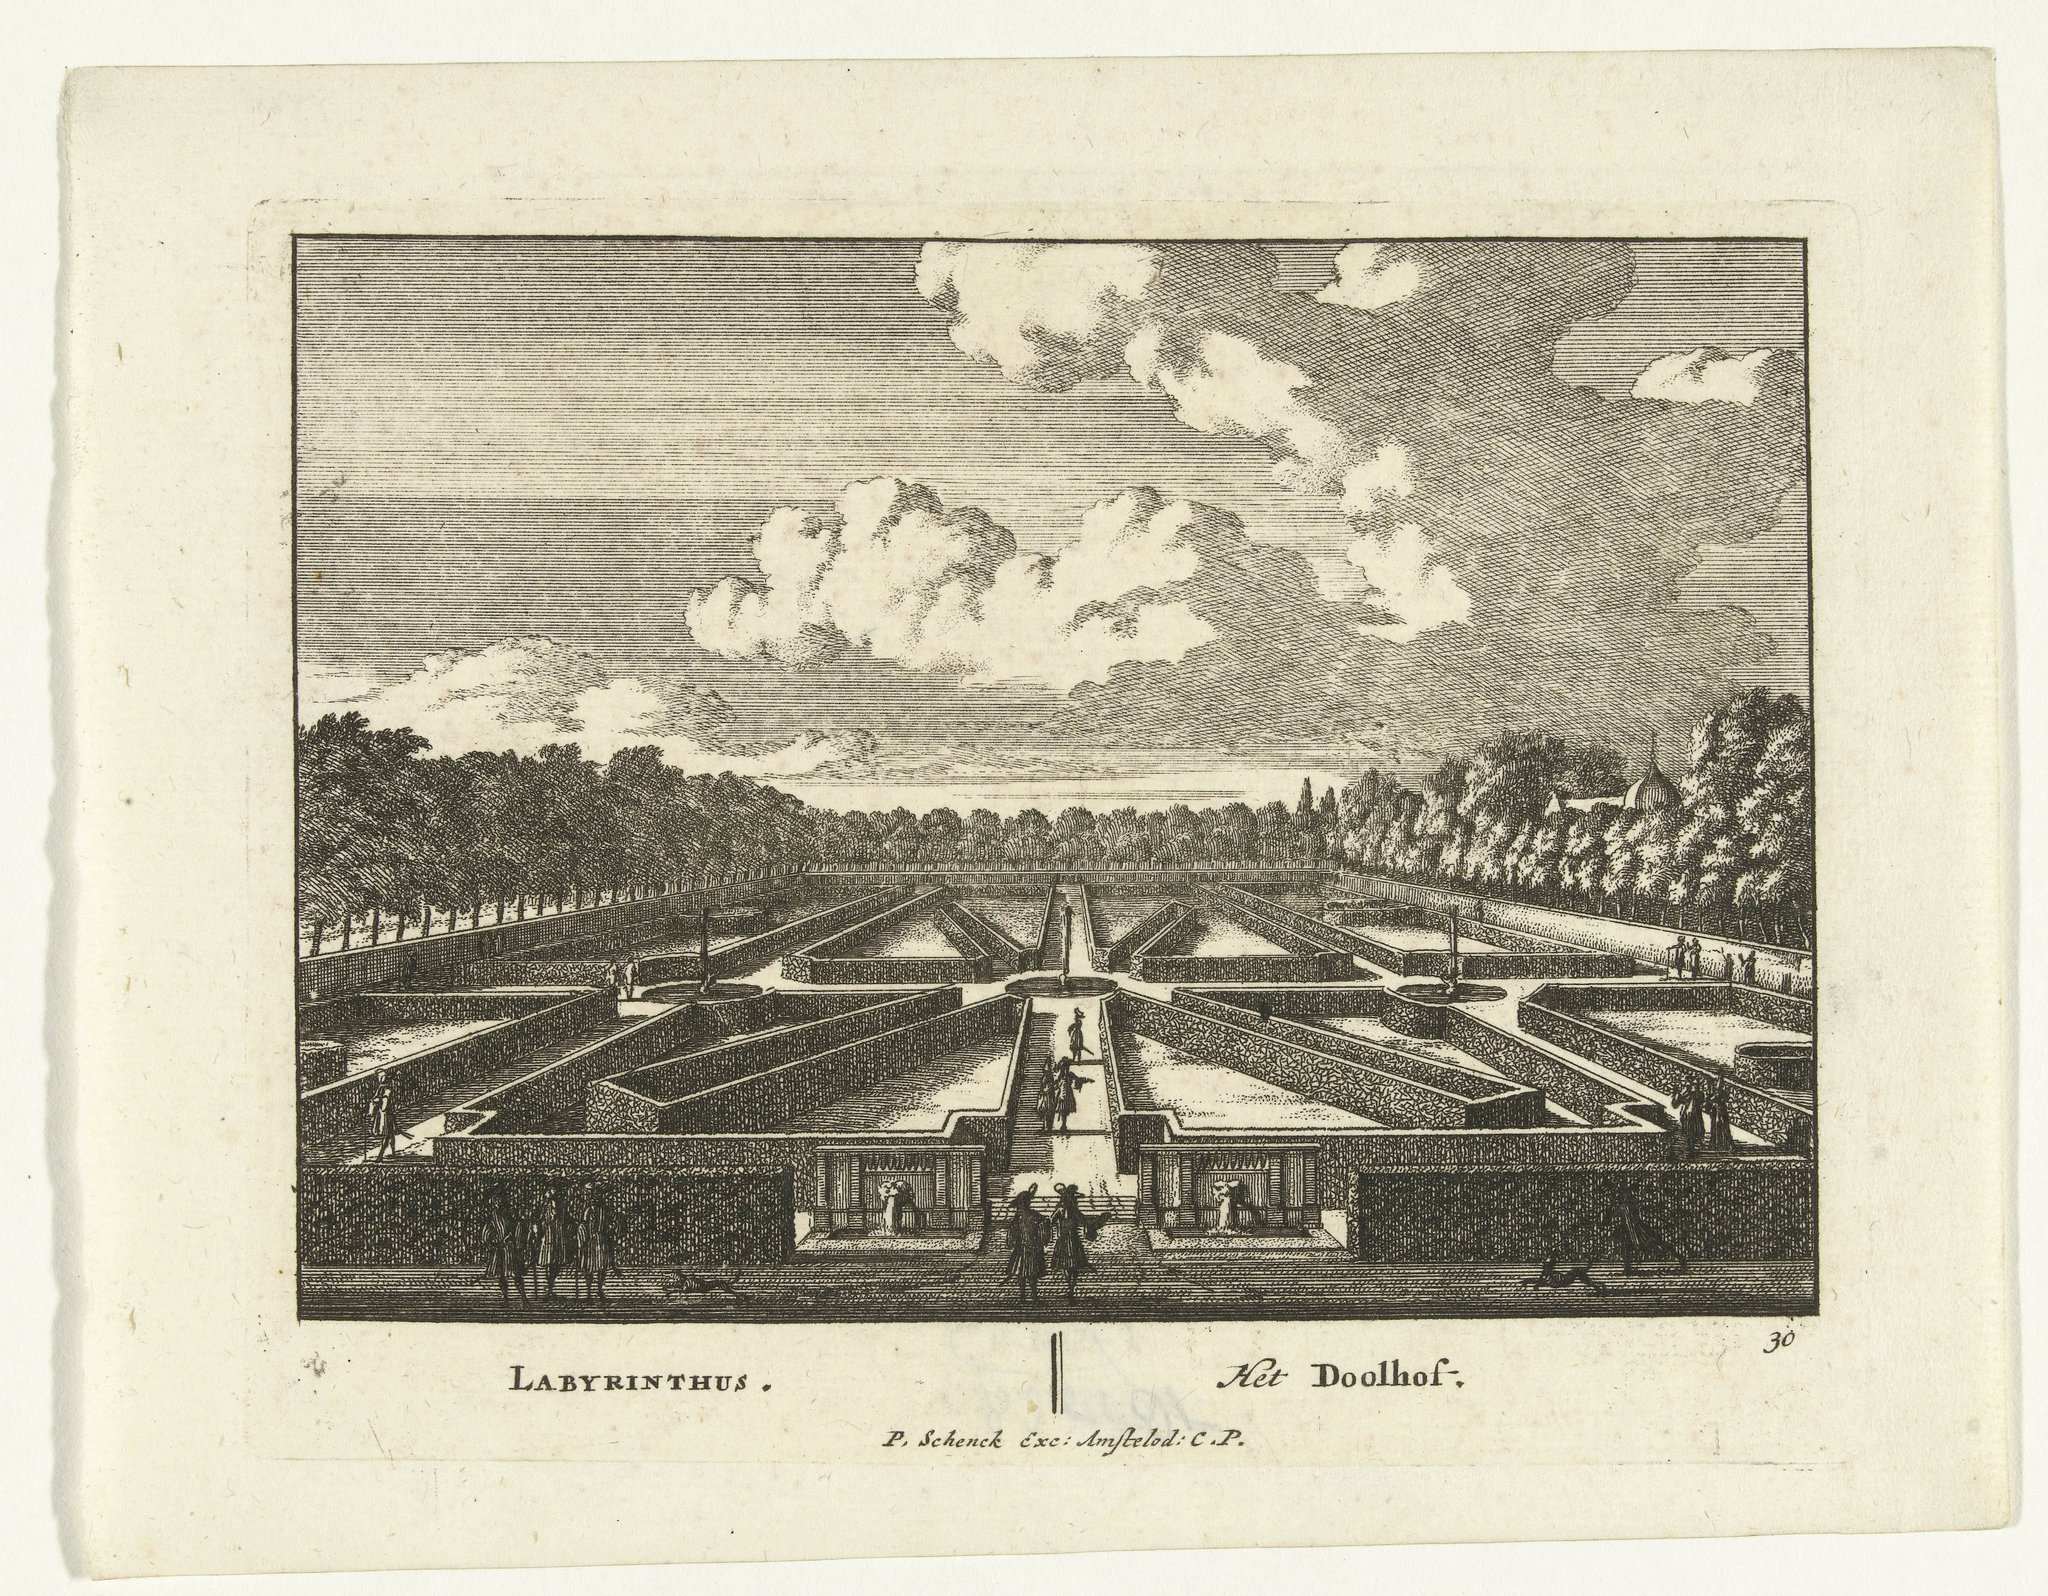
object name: print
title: Uitgeleesene Gesichte van het Wijdvermaarde Loo als andere vorstelijke Huisen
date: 1695-1705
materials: paper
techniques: etching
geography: amsterdam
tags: french or architectonic garden; formal garden, labyrinth, maze ~ garden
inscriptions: collector's mark: Lugt 2228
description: Prent uit een serie van 71 prenten met Rijnlandschappen, gezichten op vorstelijke paleizen en stadsgezichten uit Den Haag en Amsterdam.